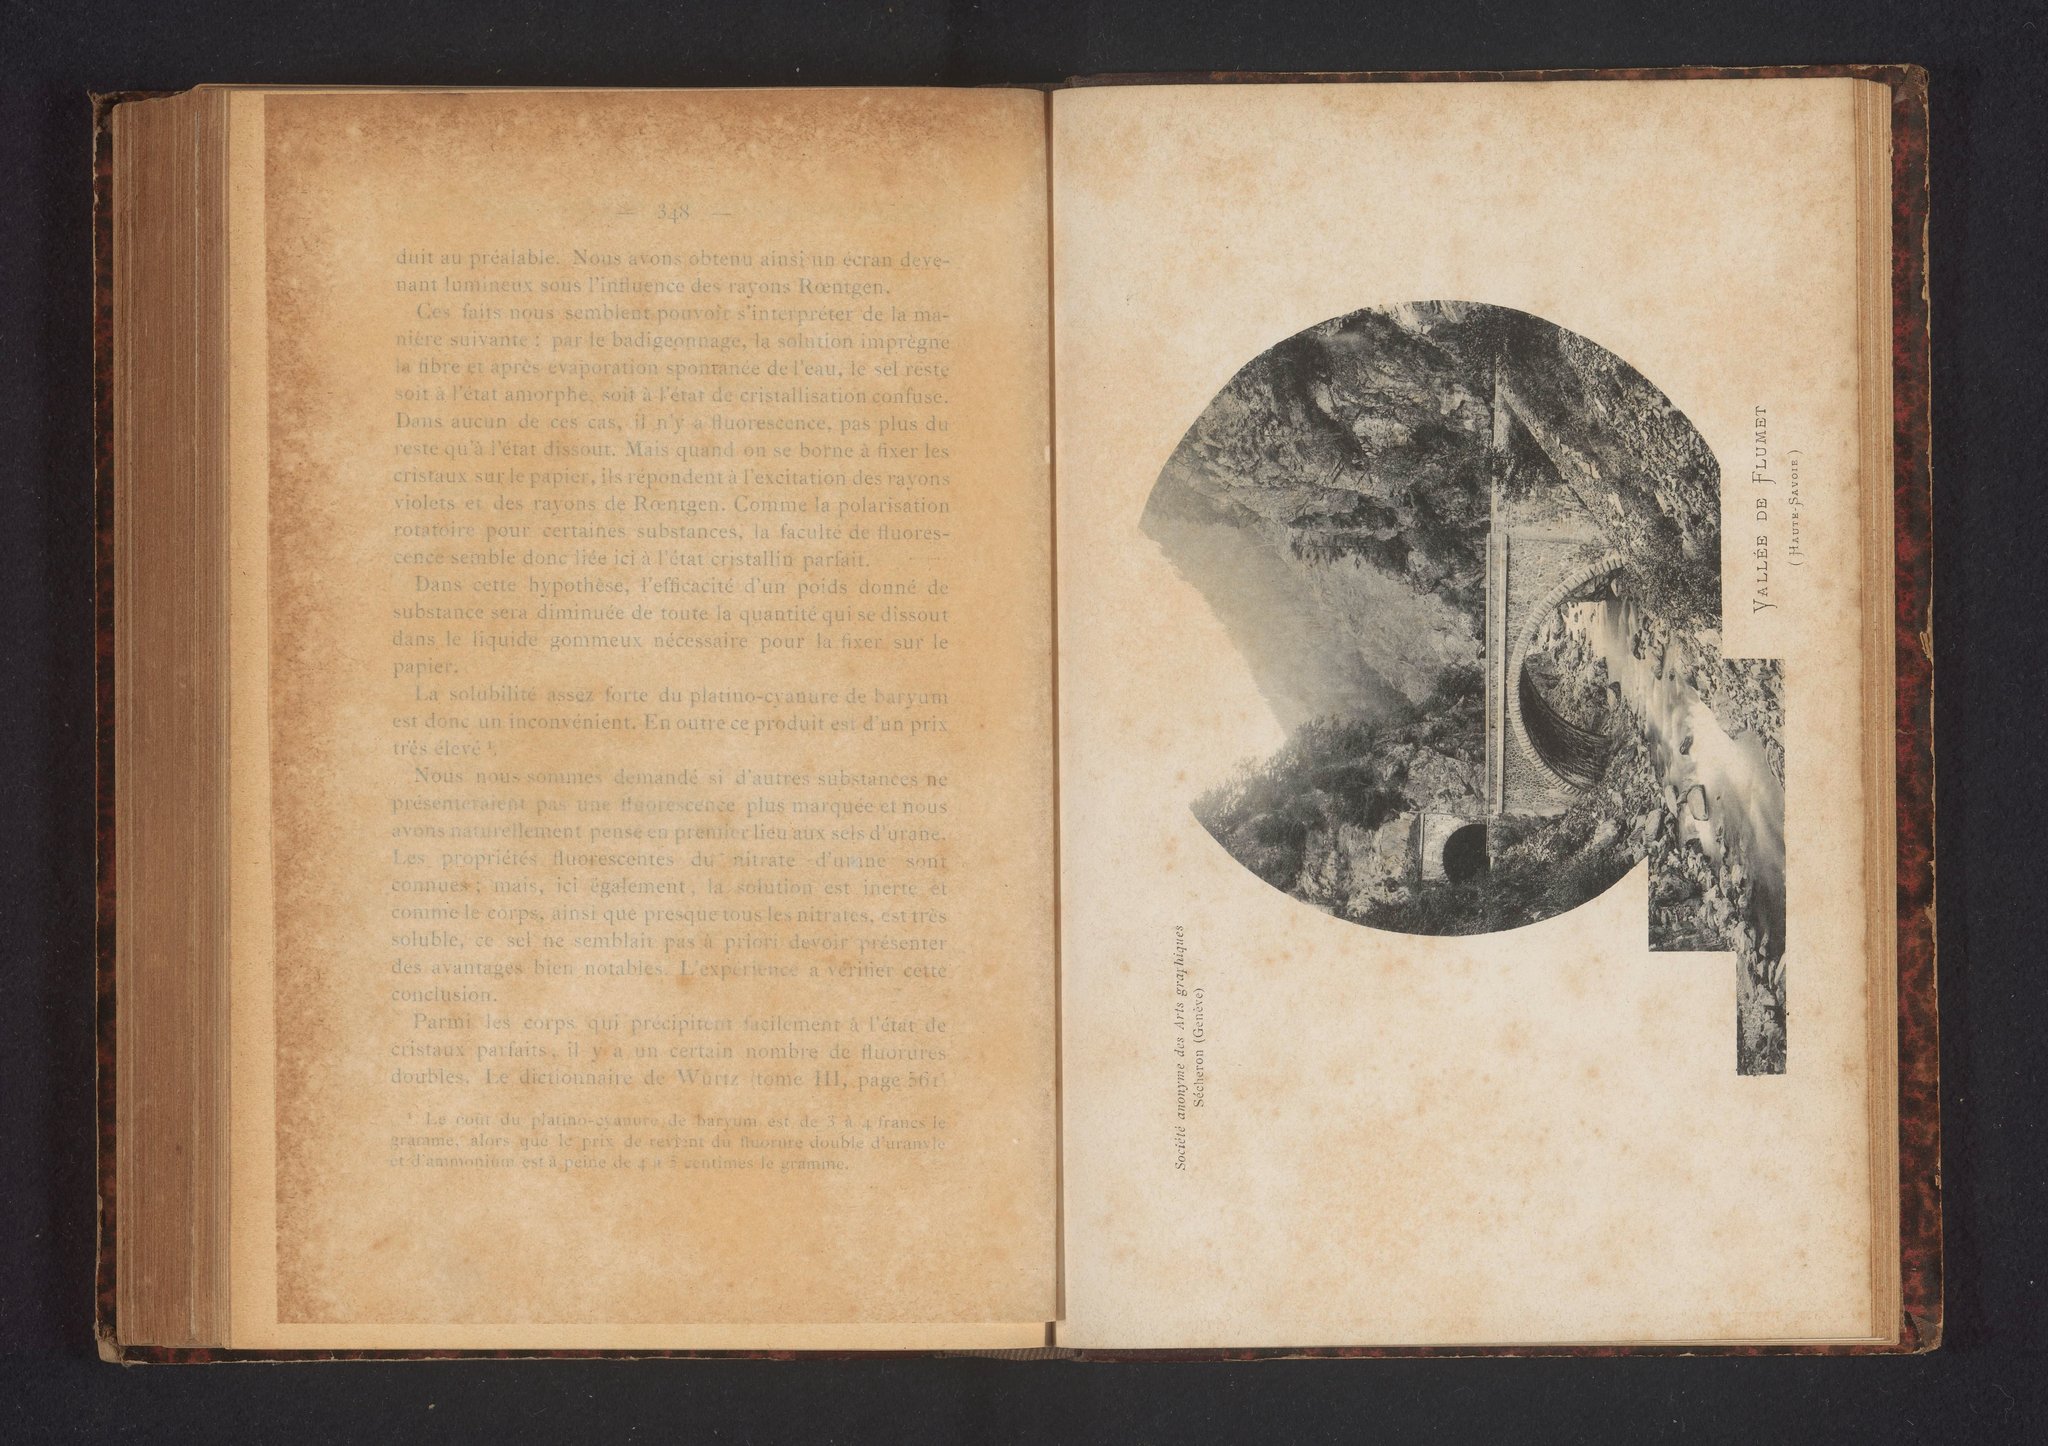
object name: photomechanical print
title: Vallée de Flumet (Haute-Savoie)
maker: Anonymous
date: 1891-1896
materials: paper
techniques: photograph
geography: flumet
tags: dale, valley, bridge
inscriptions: inscription: ‘Société anonyme des Arts graphiques/ Sécheron (Genève)’